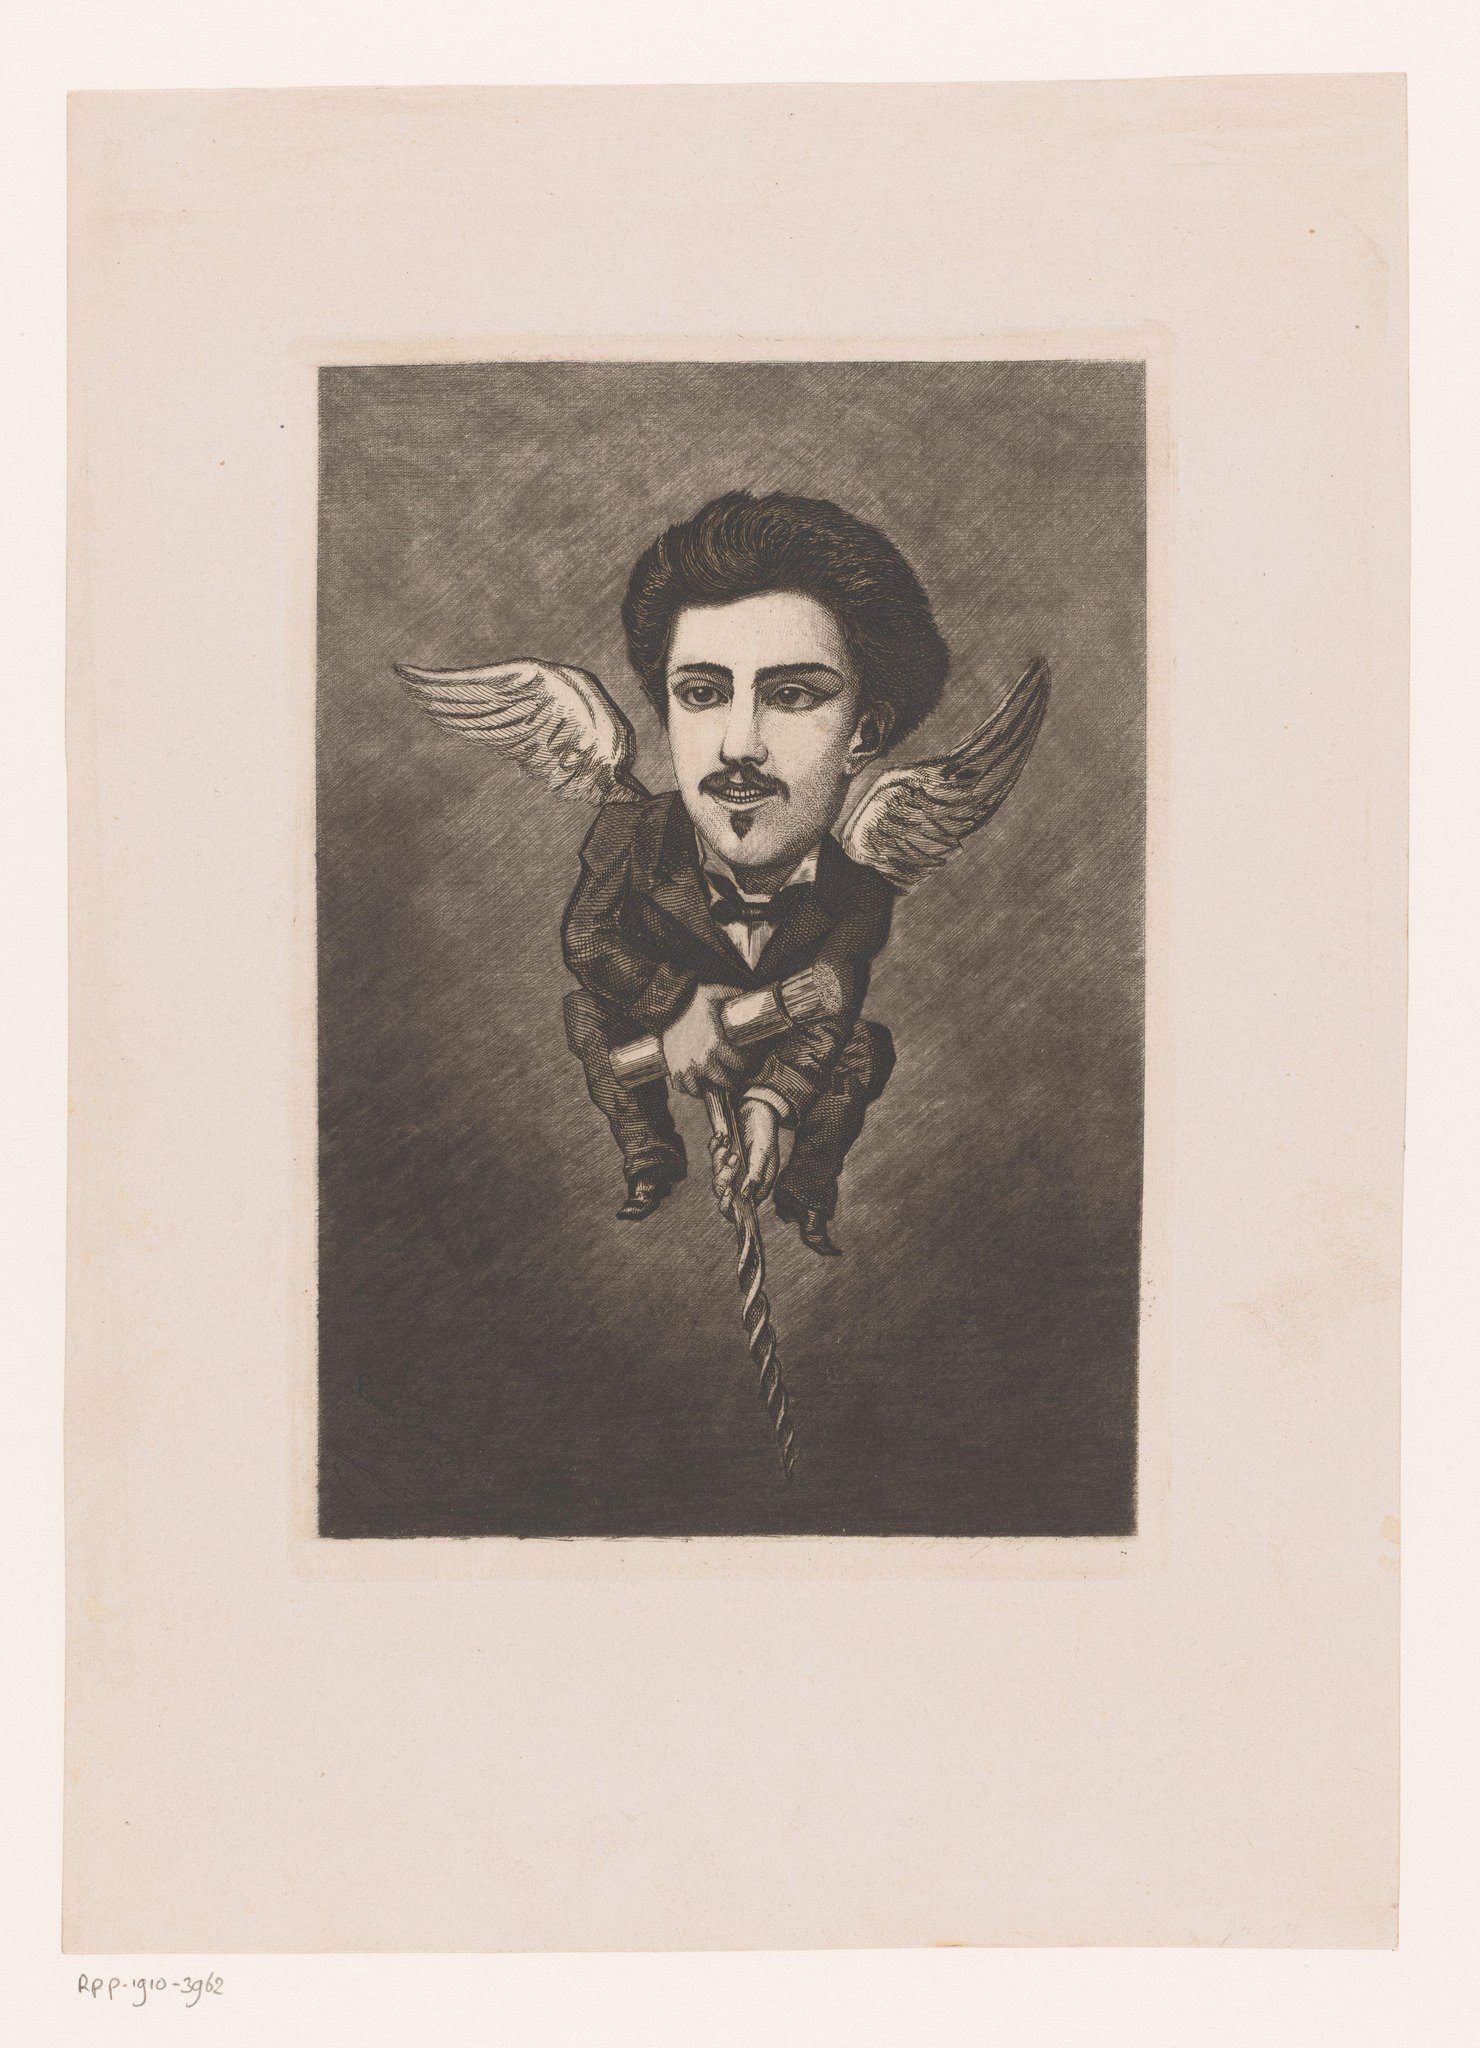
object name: print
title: Man met buitenproportioneel groot hoofd, vleugels en een kurkentrekker in zijn handen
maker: louis jaugey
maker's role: print maker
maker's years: 1837-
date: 1878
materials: paper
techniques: etching, intaglio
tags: adult man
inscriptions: collector's mark: Lugt 2228